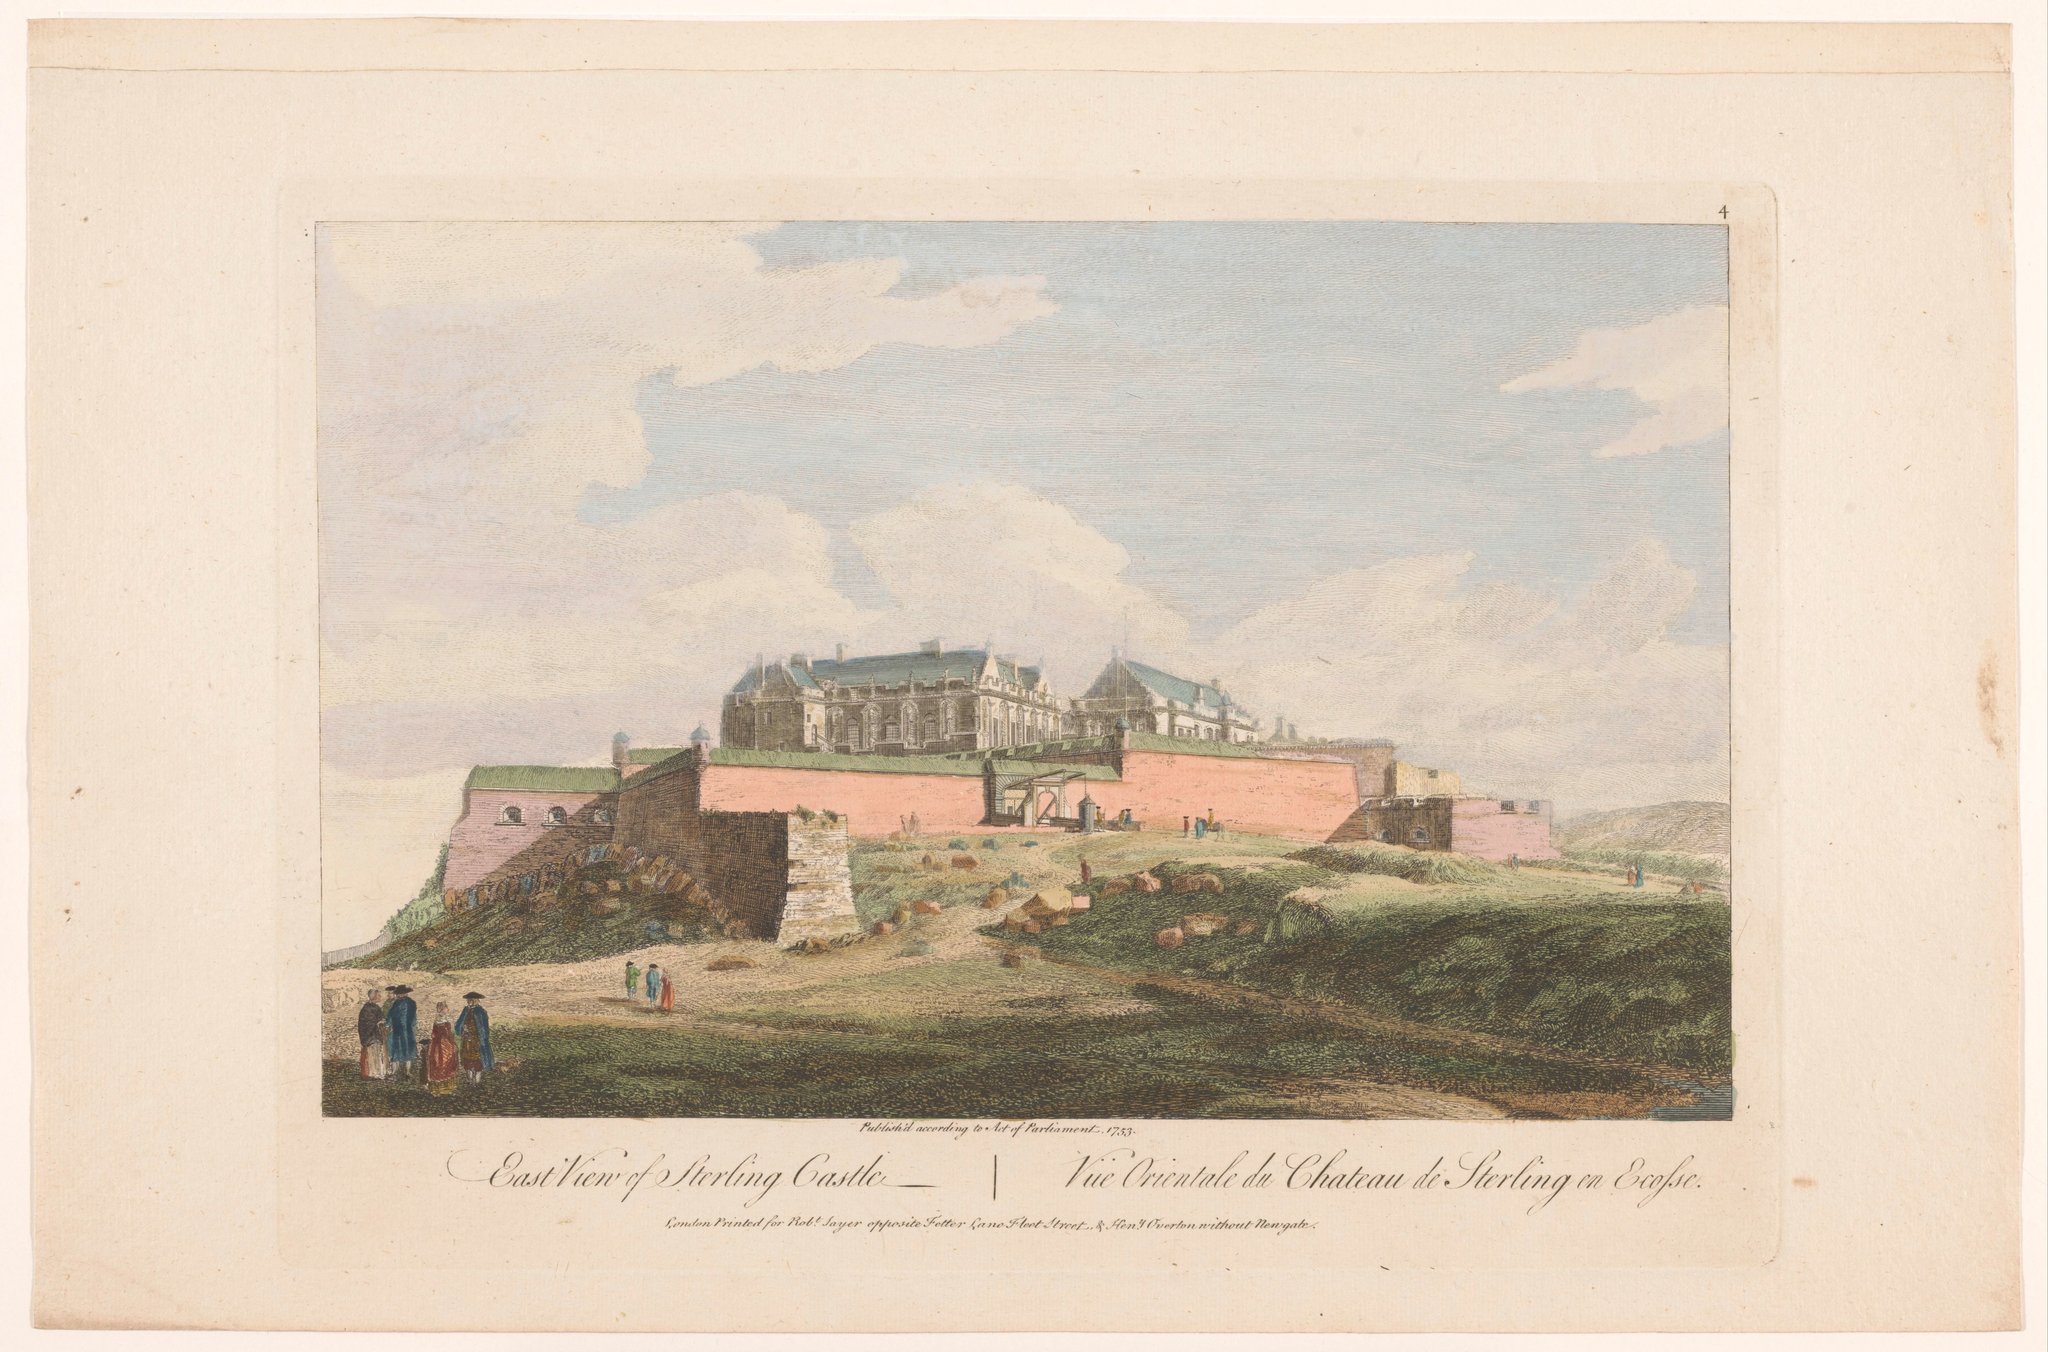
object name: print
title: Schotland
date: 1753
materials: paper, watercolor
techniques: brush, etching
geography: great britain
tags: castle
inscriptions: date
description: De serie “Schotland” bevat acht prenten met de nummers 1-8, waarvan dit nummer 4 is.